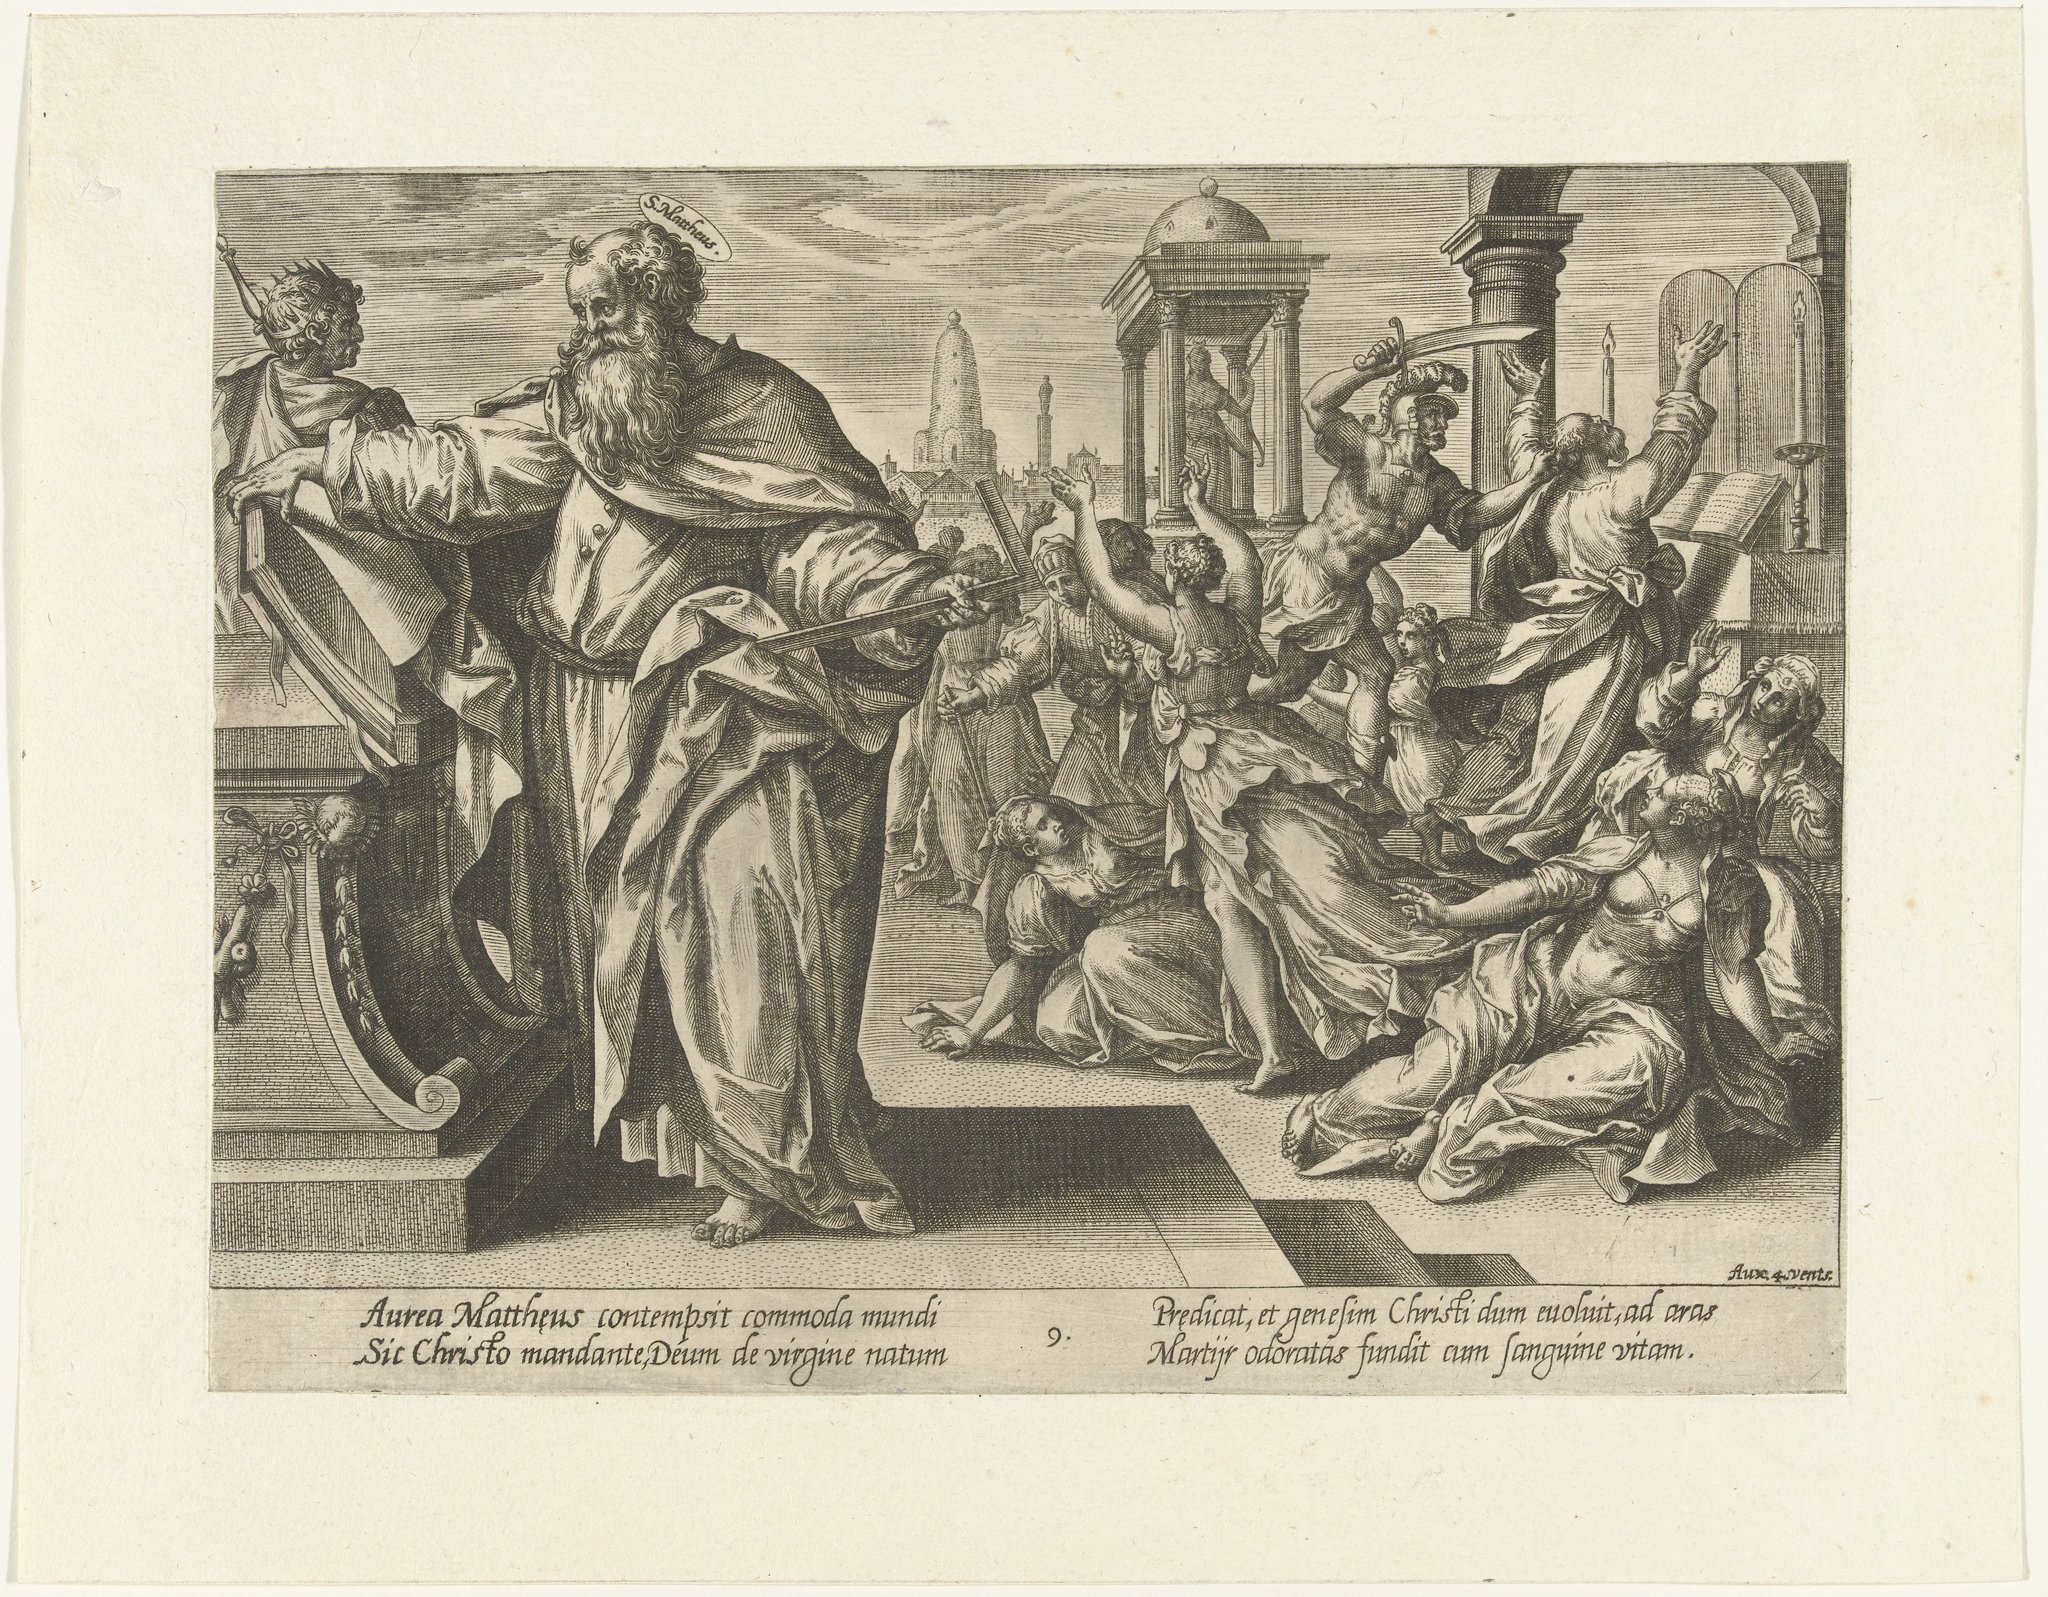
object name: print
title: Het martelaarschap van Christus en de apostelen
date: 1577-1582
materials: paper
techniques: engraving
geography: antwerp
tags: matthew is slain before an altar by soldiers of hirtacus and is beheaded, the apostle and evangelist matthew (mattheus); possible attributes: angel, axe, book, halberd, pen and inkhorn, purse, scroll, square, sword - martyrdom, suffering, misfortune, death of male saint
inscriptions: collector's mark: Lugt 240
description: Mattheüs wordt met een zwaard doodgeslagen terwijl hij mis leest; links naast het tafereel van zijn marteldood staat hij nogmaals afgebeeld, met een winkelhaak in de hand. Onder de voorstelling tweemaal twee regels Latijn. Deze prent is onderdeel van een serie van 13 prenten van Christus (ongenummerd) en de apostelen (genummerd), meer specifiek van de martelingen die ze hebben ondergaan.